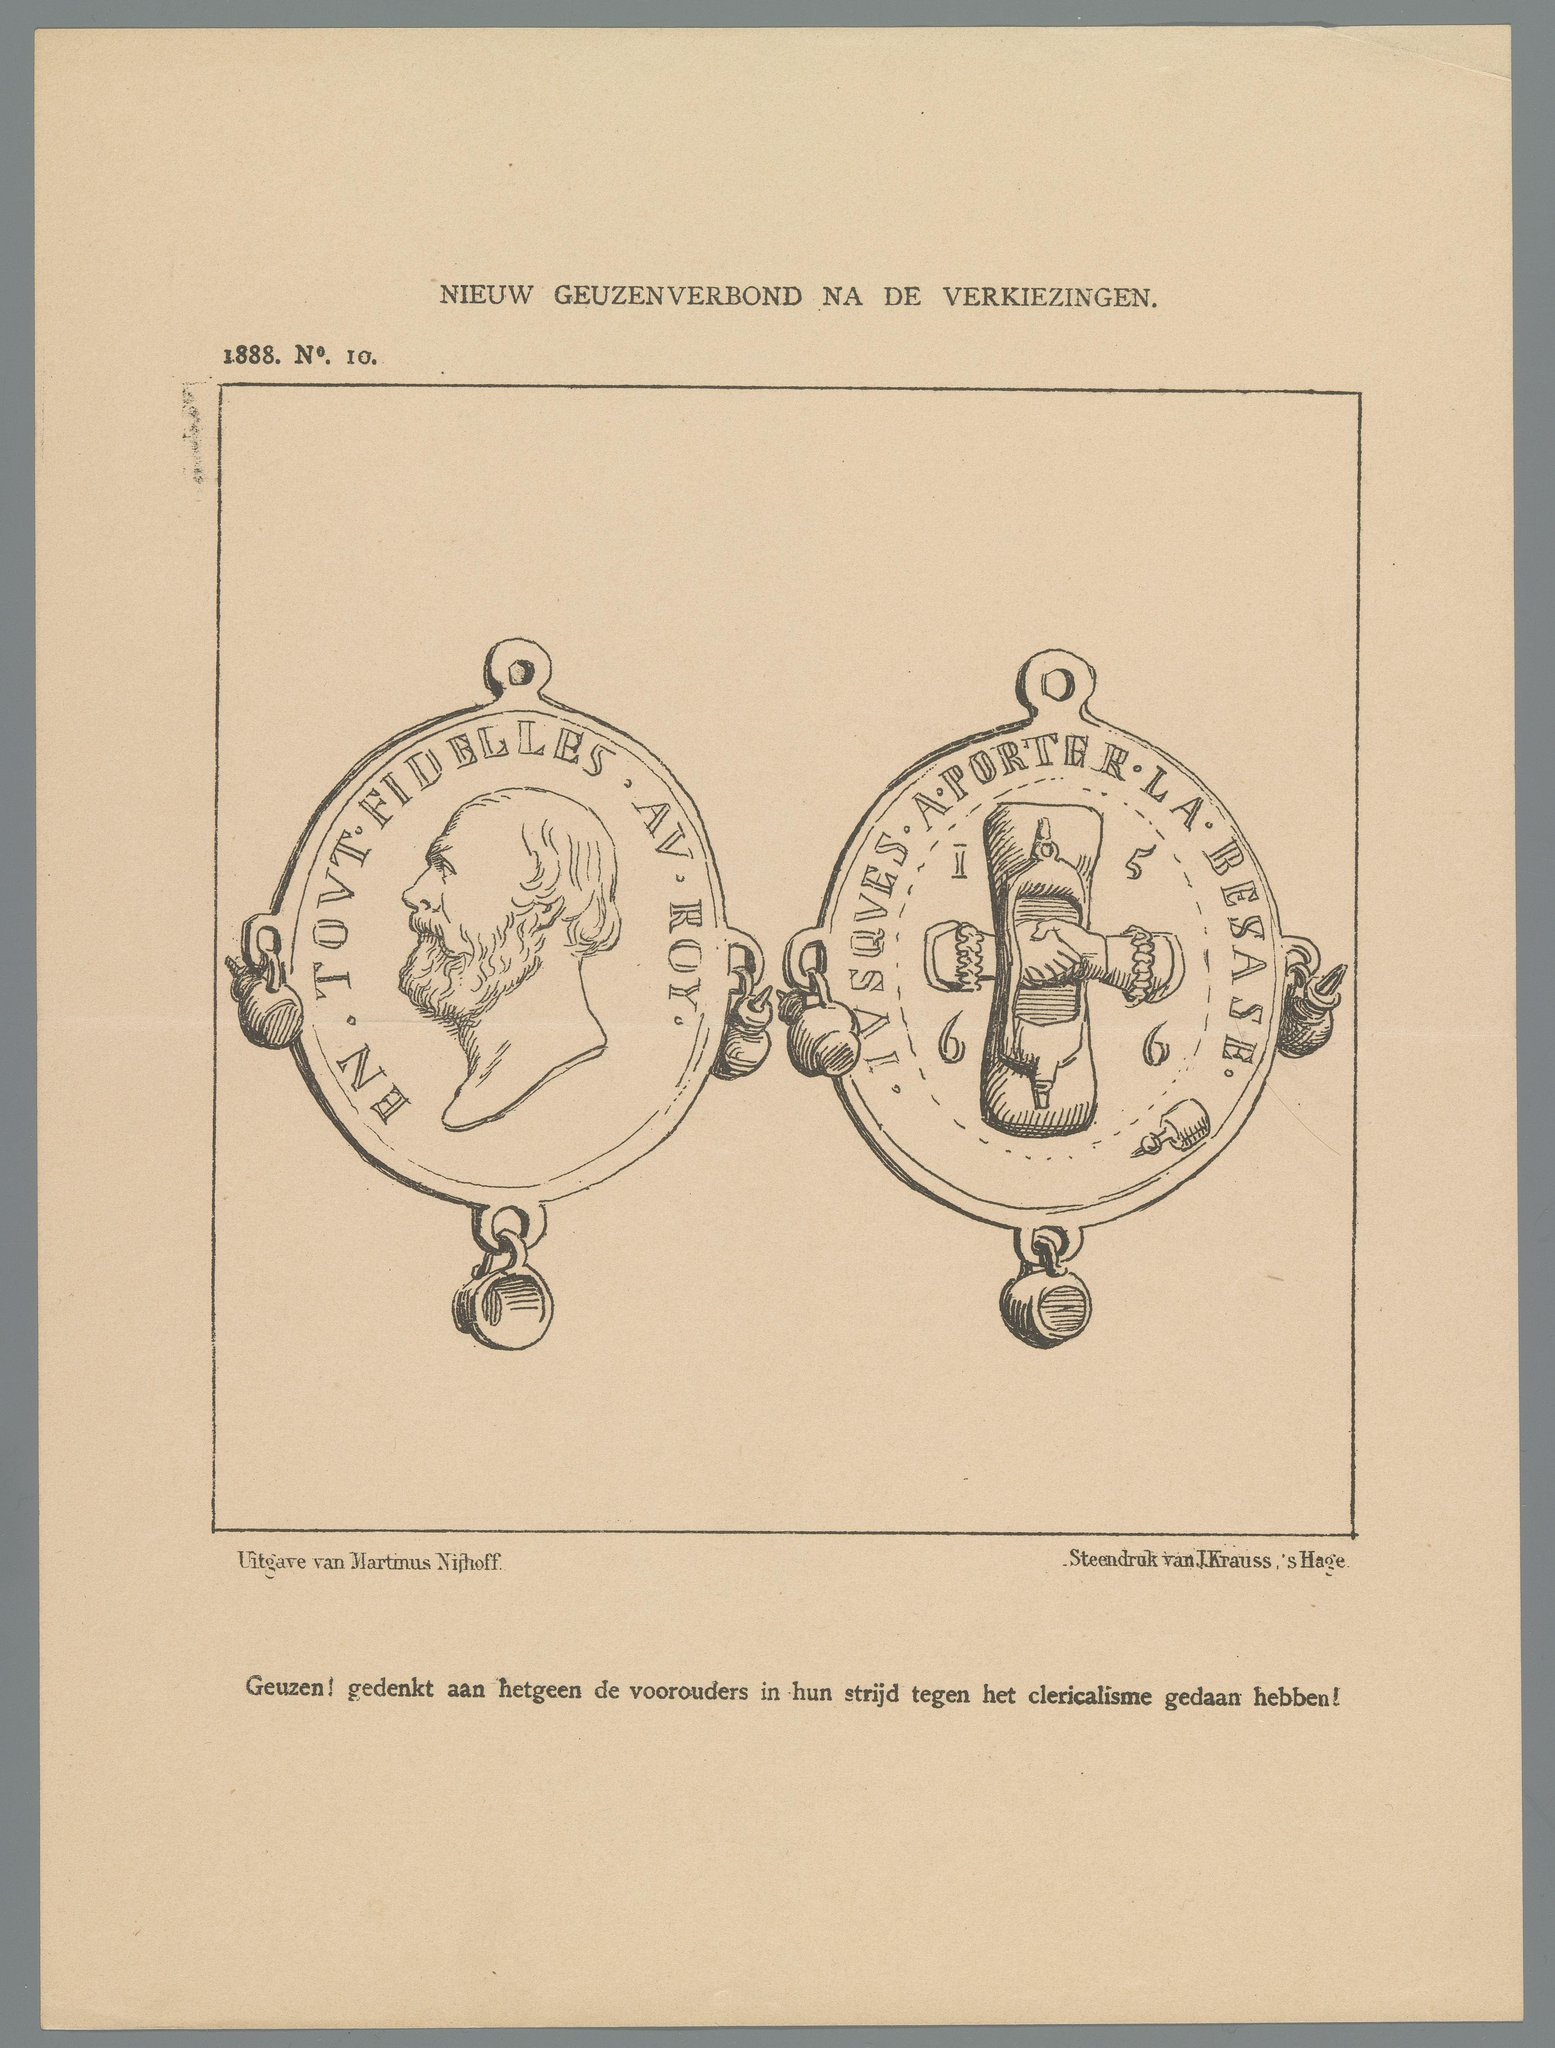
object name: print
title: Spotprent over de strijd tegen het clericalisme, 1888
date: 1888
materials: paper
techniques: lithograph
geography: the hague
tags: brussels, willem iii (koning der nederlanden)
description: Spotprent over de strijd tegen het clericalisme: geuzenpenning mmet portret van koning Willem III. Plaat verschenen bij het weekblad De Nederlandsche Spectator, nr. 10, 1888.